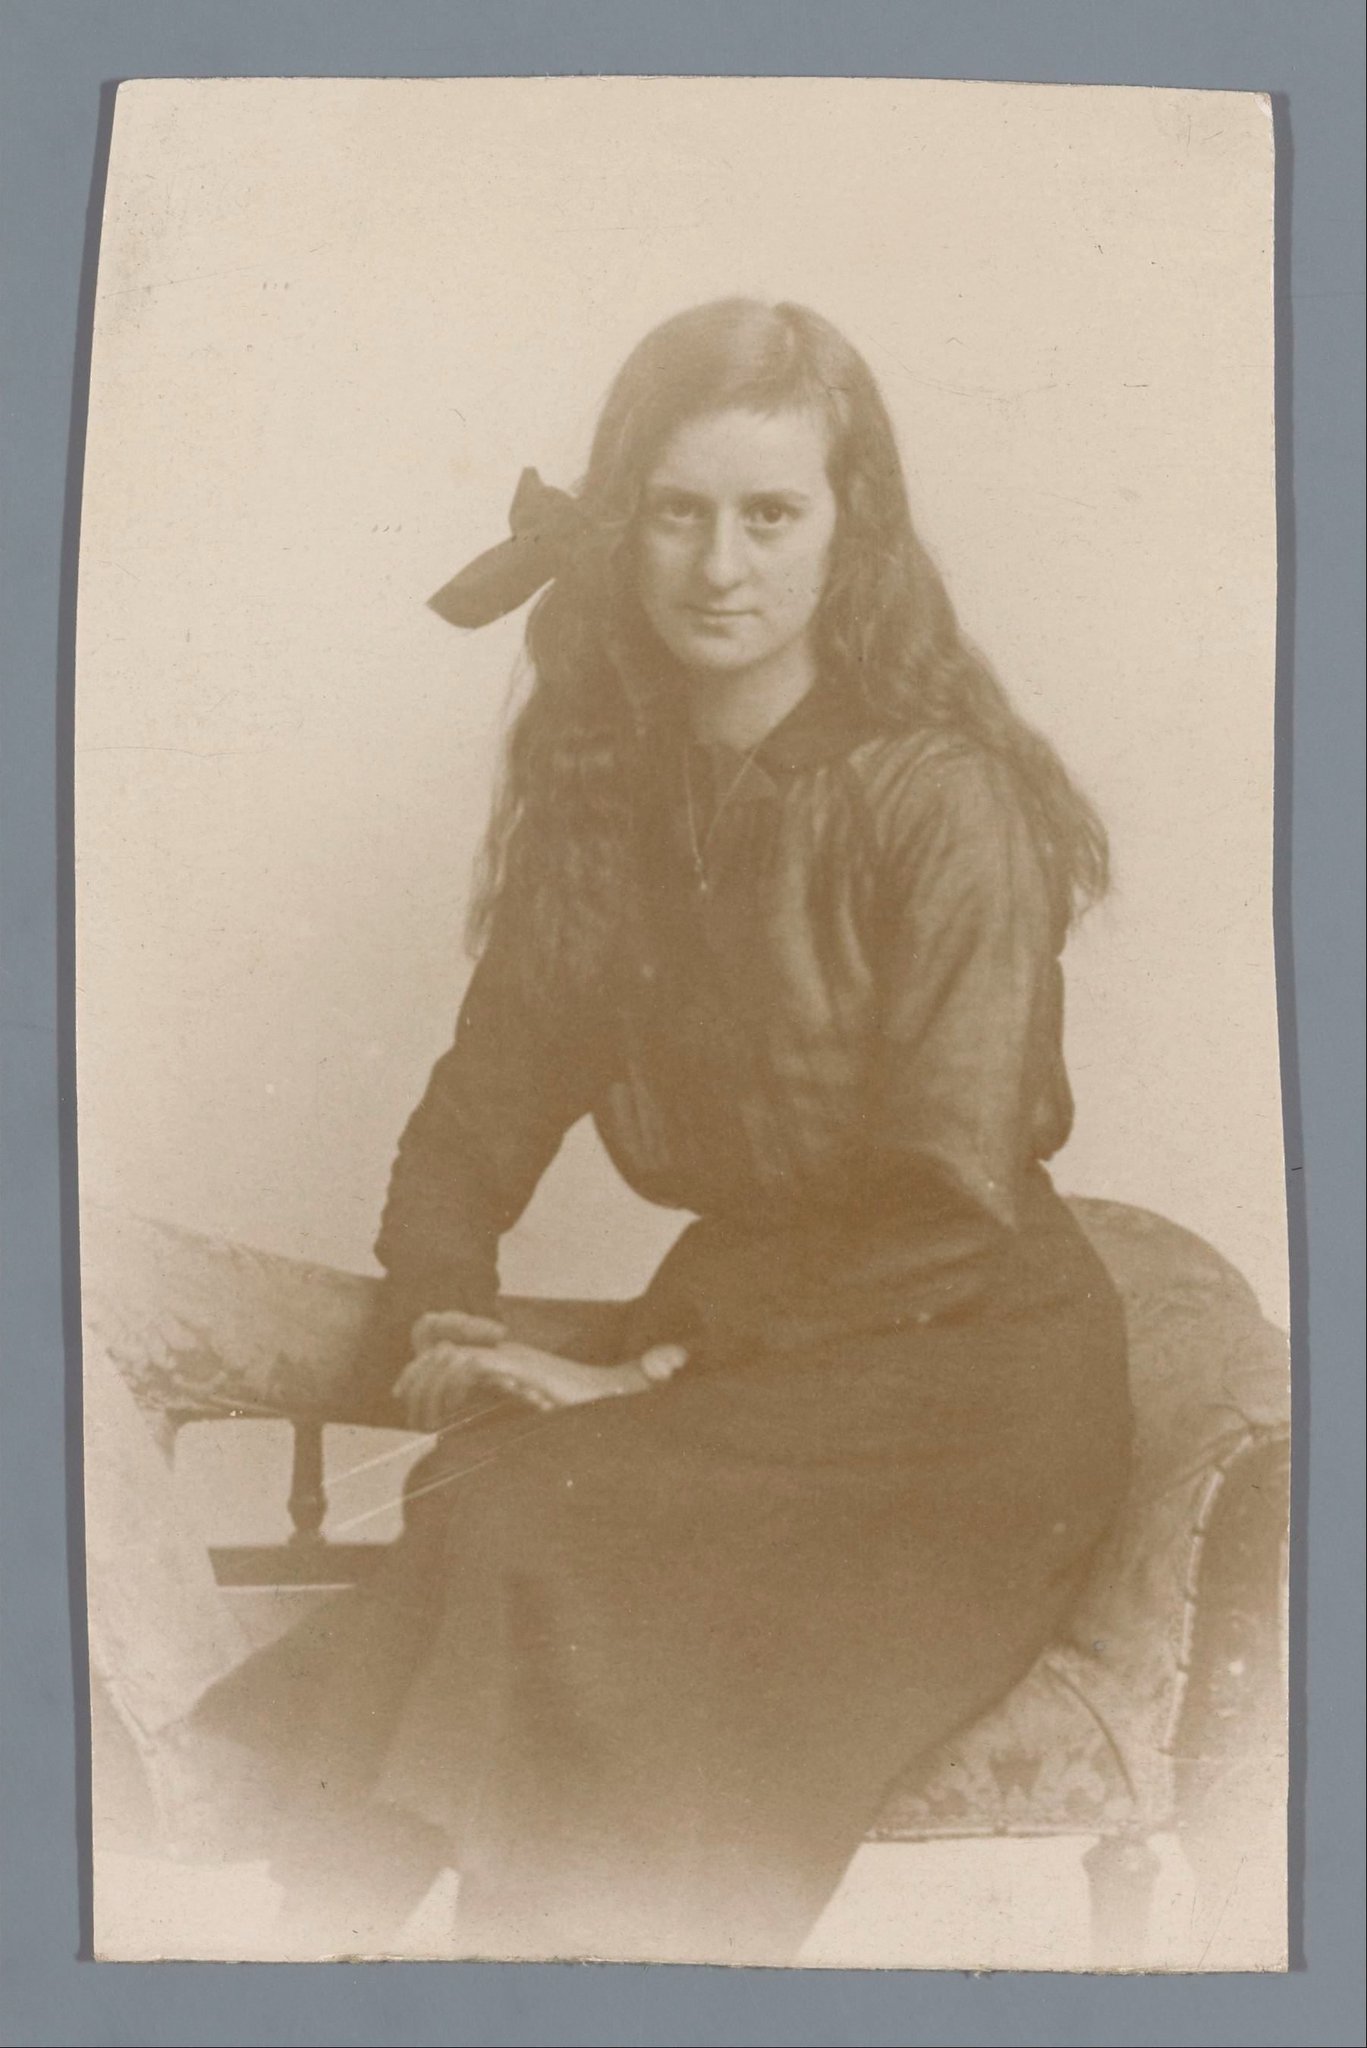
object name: photograph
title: Portret van een onbekende vrouw met een strik in haar haar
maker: Anonymous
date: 1905-1920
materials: photographic support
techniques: gelatin silver print, snipping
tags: adult woman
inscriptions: inscription: ‘Post Card British Made [...]rrespondence Address 062[...]’